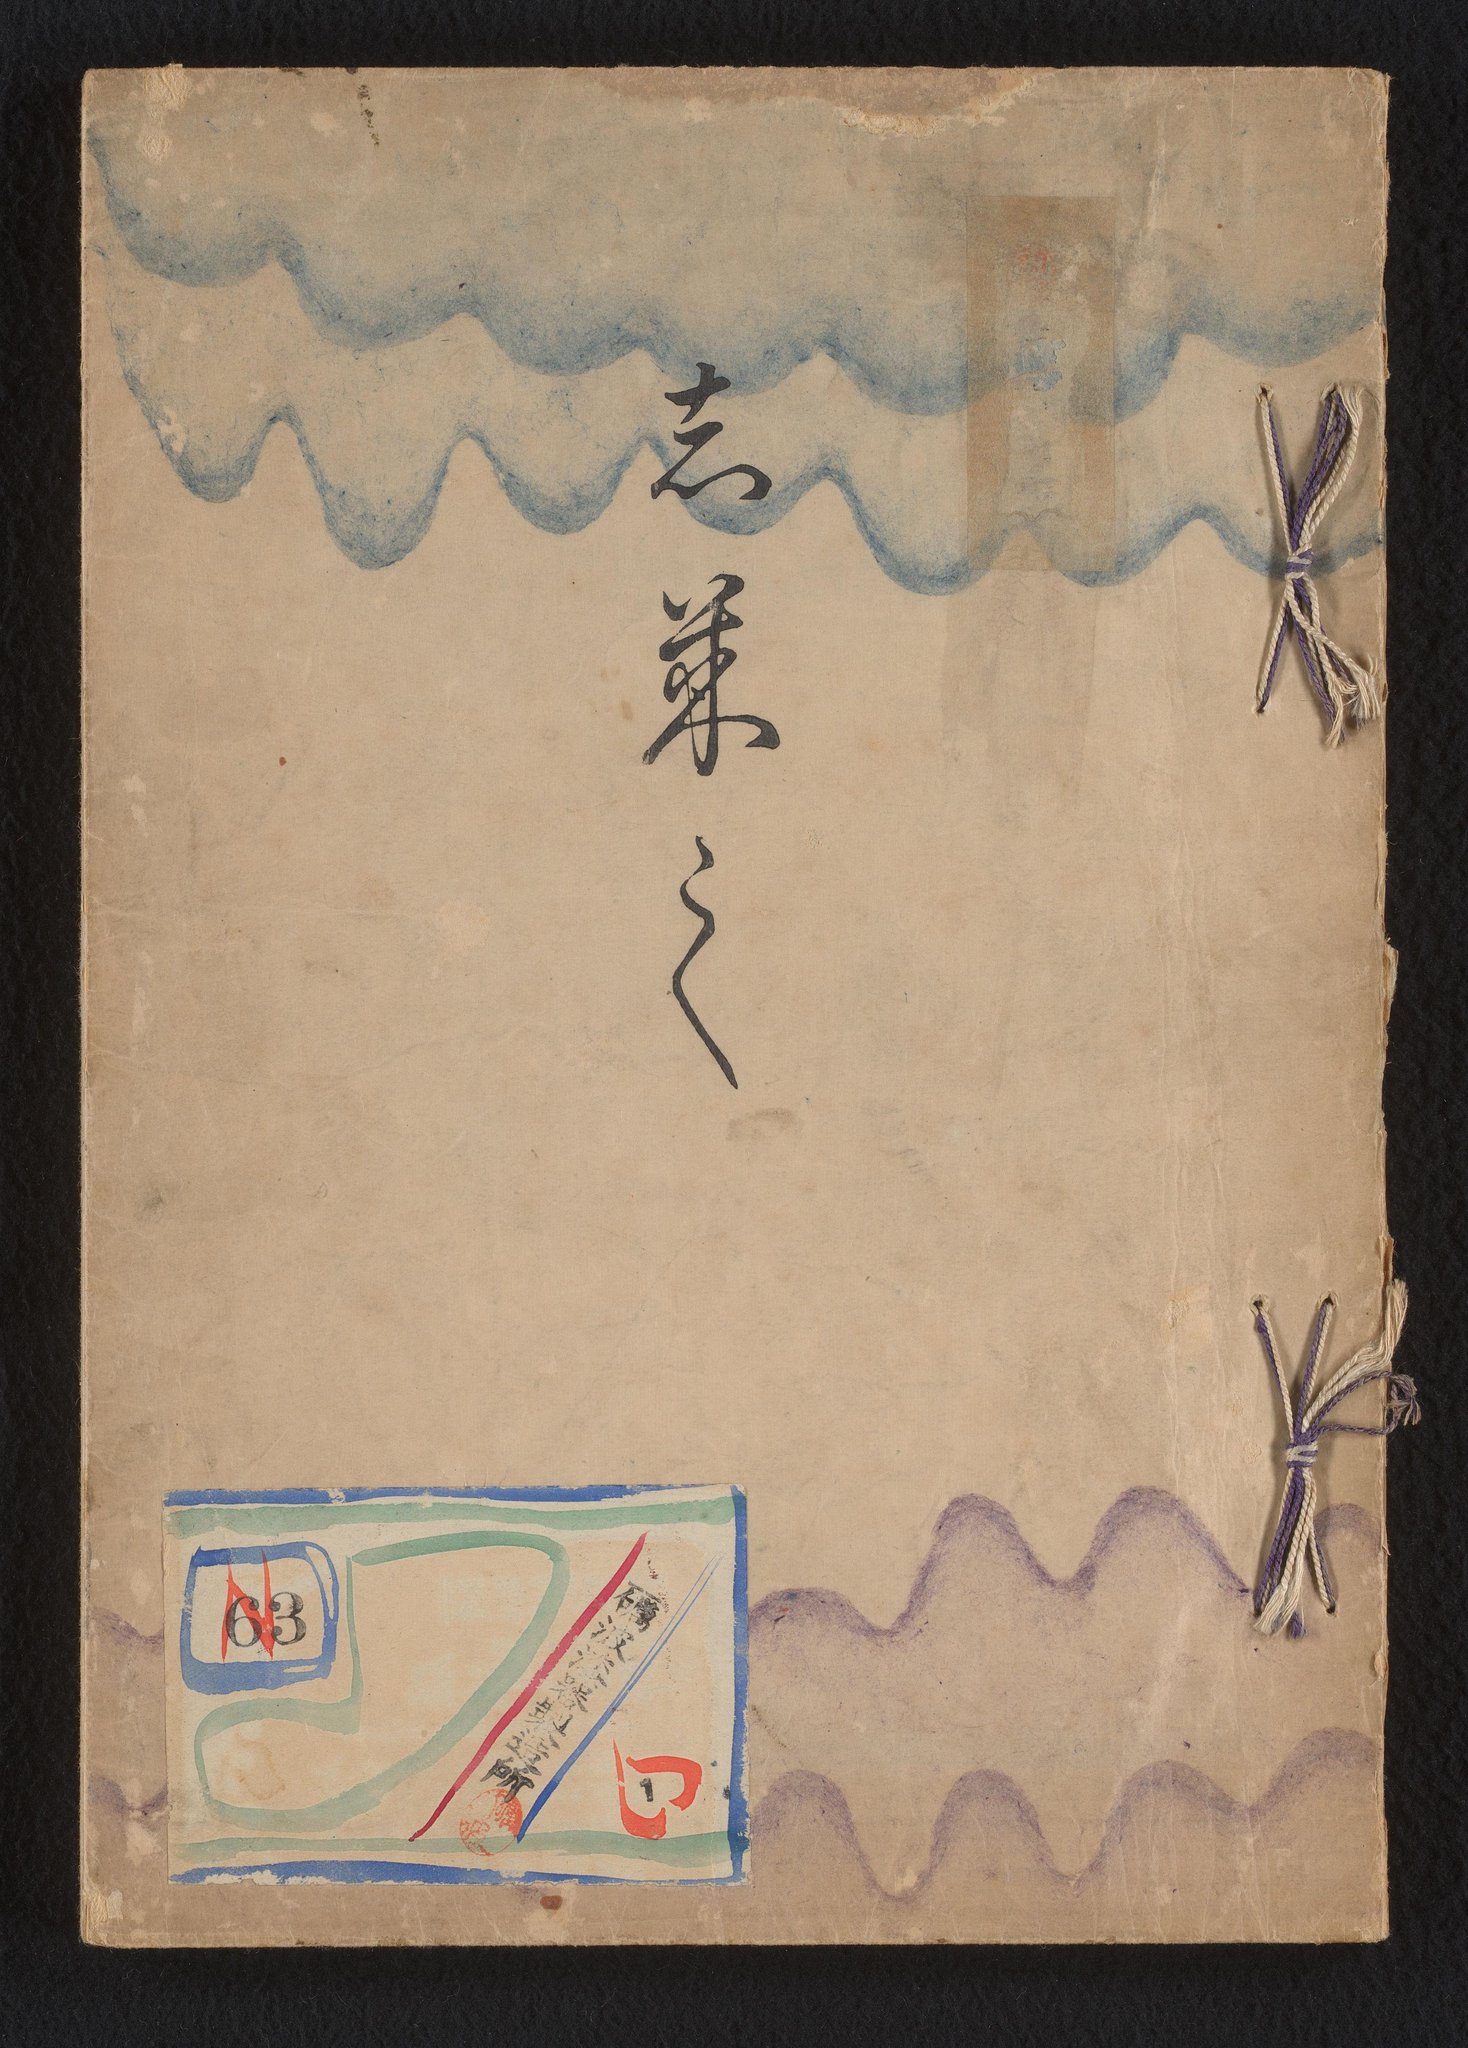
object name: book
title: Vierkante ontwerpen deel één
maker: kamisaka sekka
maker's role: print maker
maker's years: 1866-1942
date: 1901-1902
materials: paper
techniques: woodcut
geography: kyoto